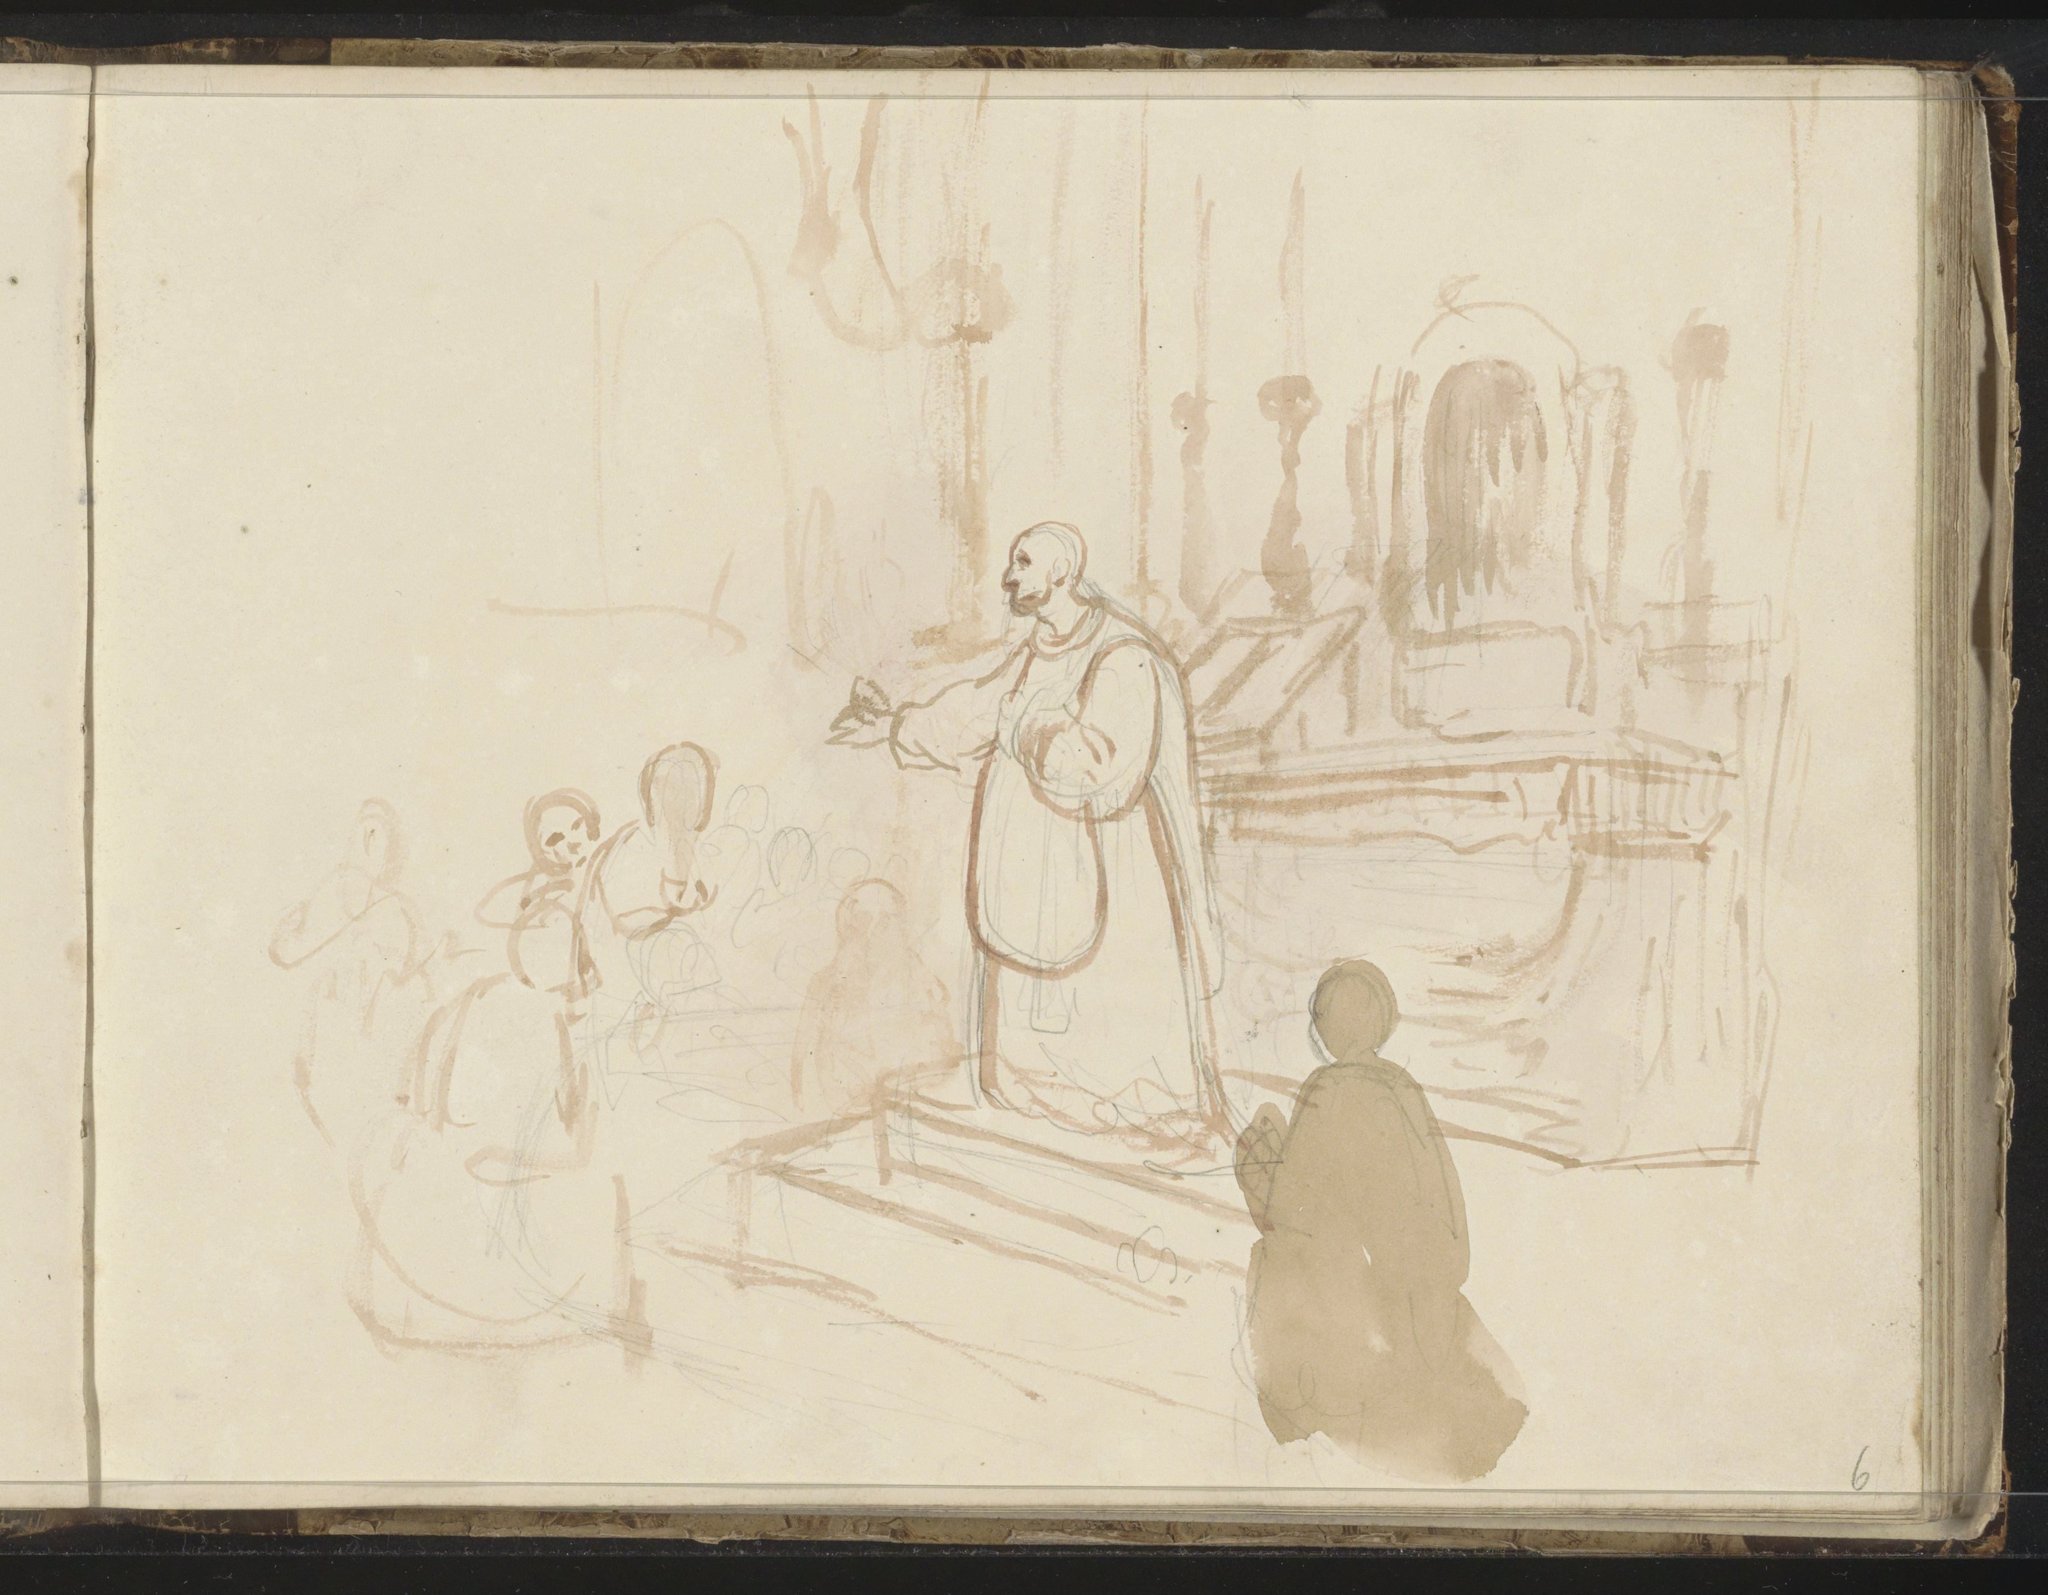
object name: sketchbook leaf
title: Gebarende monnik en figuren in een interieur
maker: willem hendrik schmidt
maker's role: draughtsman, painter, print maker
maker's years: 1809-1849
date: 1819-1849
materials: paper, pencil, watercolor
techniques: brush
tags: postures and gestures of arms and hands in general, monk(s), friar(s)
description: Vermoedelijk het interieur van een kerk of klooster. De monnik richt zich met zijn armgebaar tot de aanwezigen. Blad 6 recto uit een schetsboek met 52 bladen.